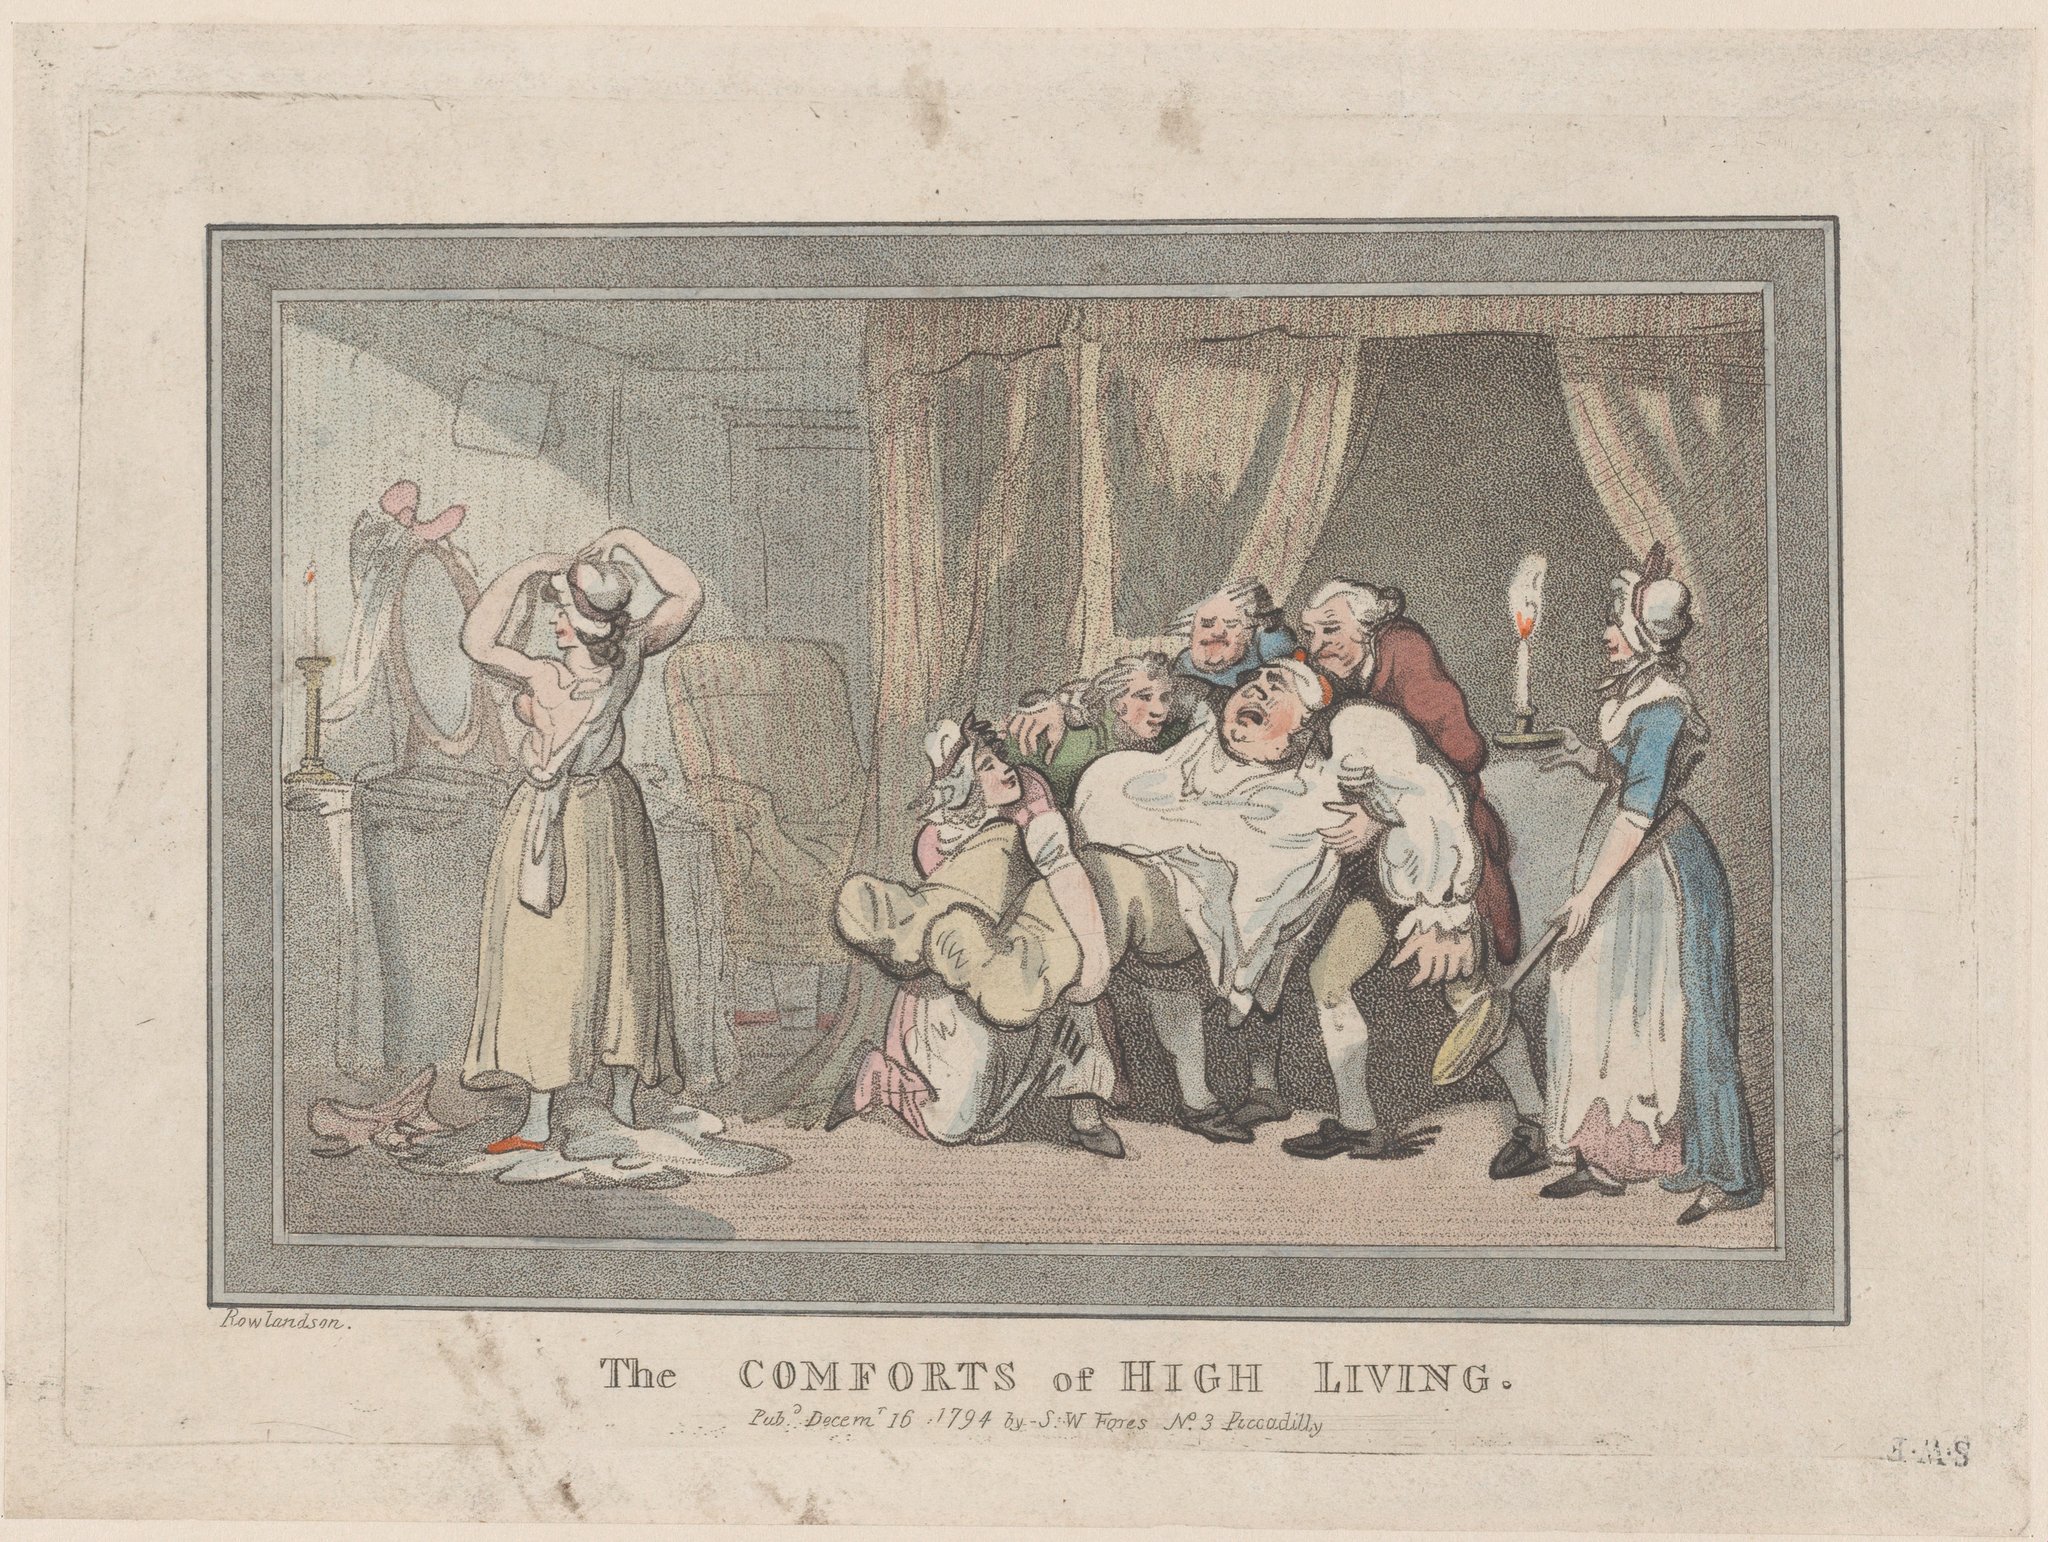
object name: print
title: The Comforts of High Living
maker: thomas rowlandson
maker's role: artist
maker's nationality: british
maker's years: 1757-1827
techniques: etching, stippling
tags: satire,bedrooms,men,women,servants